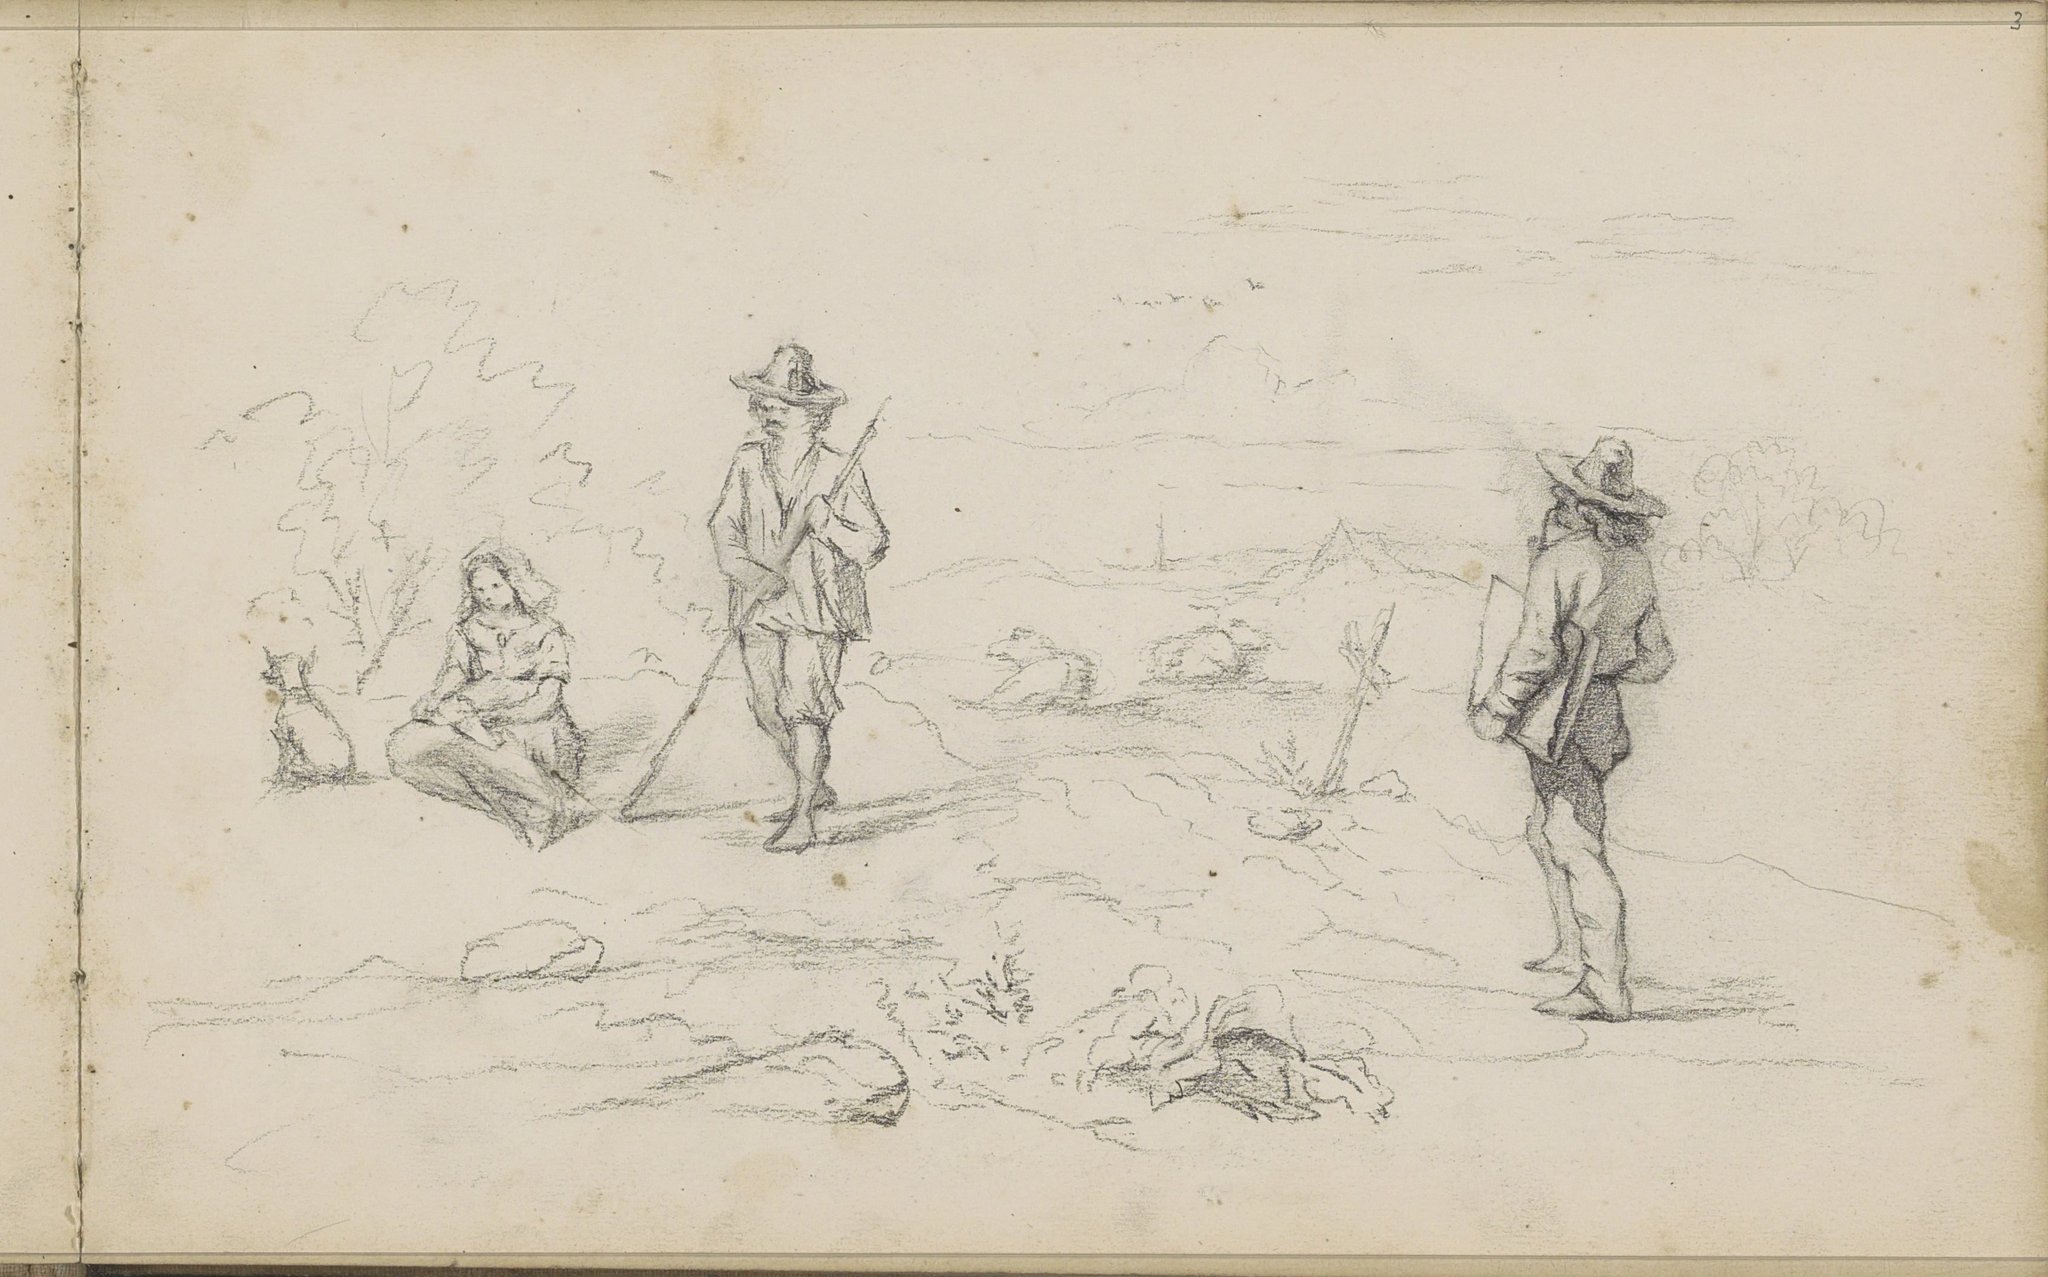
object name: sketchbook leaf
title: Twee mannen en een zittende vrouw in een heuvellandschap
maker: willem cornelis rip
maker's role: draughtsman, painter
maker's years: 1856-1922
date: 1874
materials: paper, pencil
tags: low hill country (+ landscape with figures, staffage)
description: Blad 3 recto uit een schetsboek met 47 bladen.